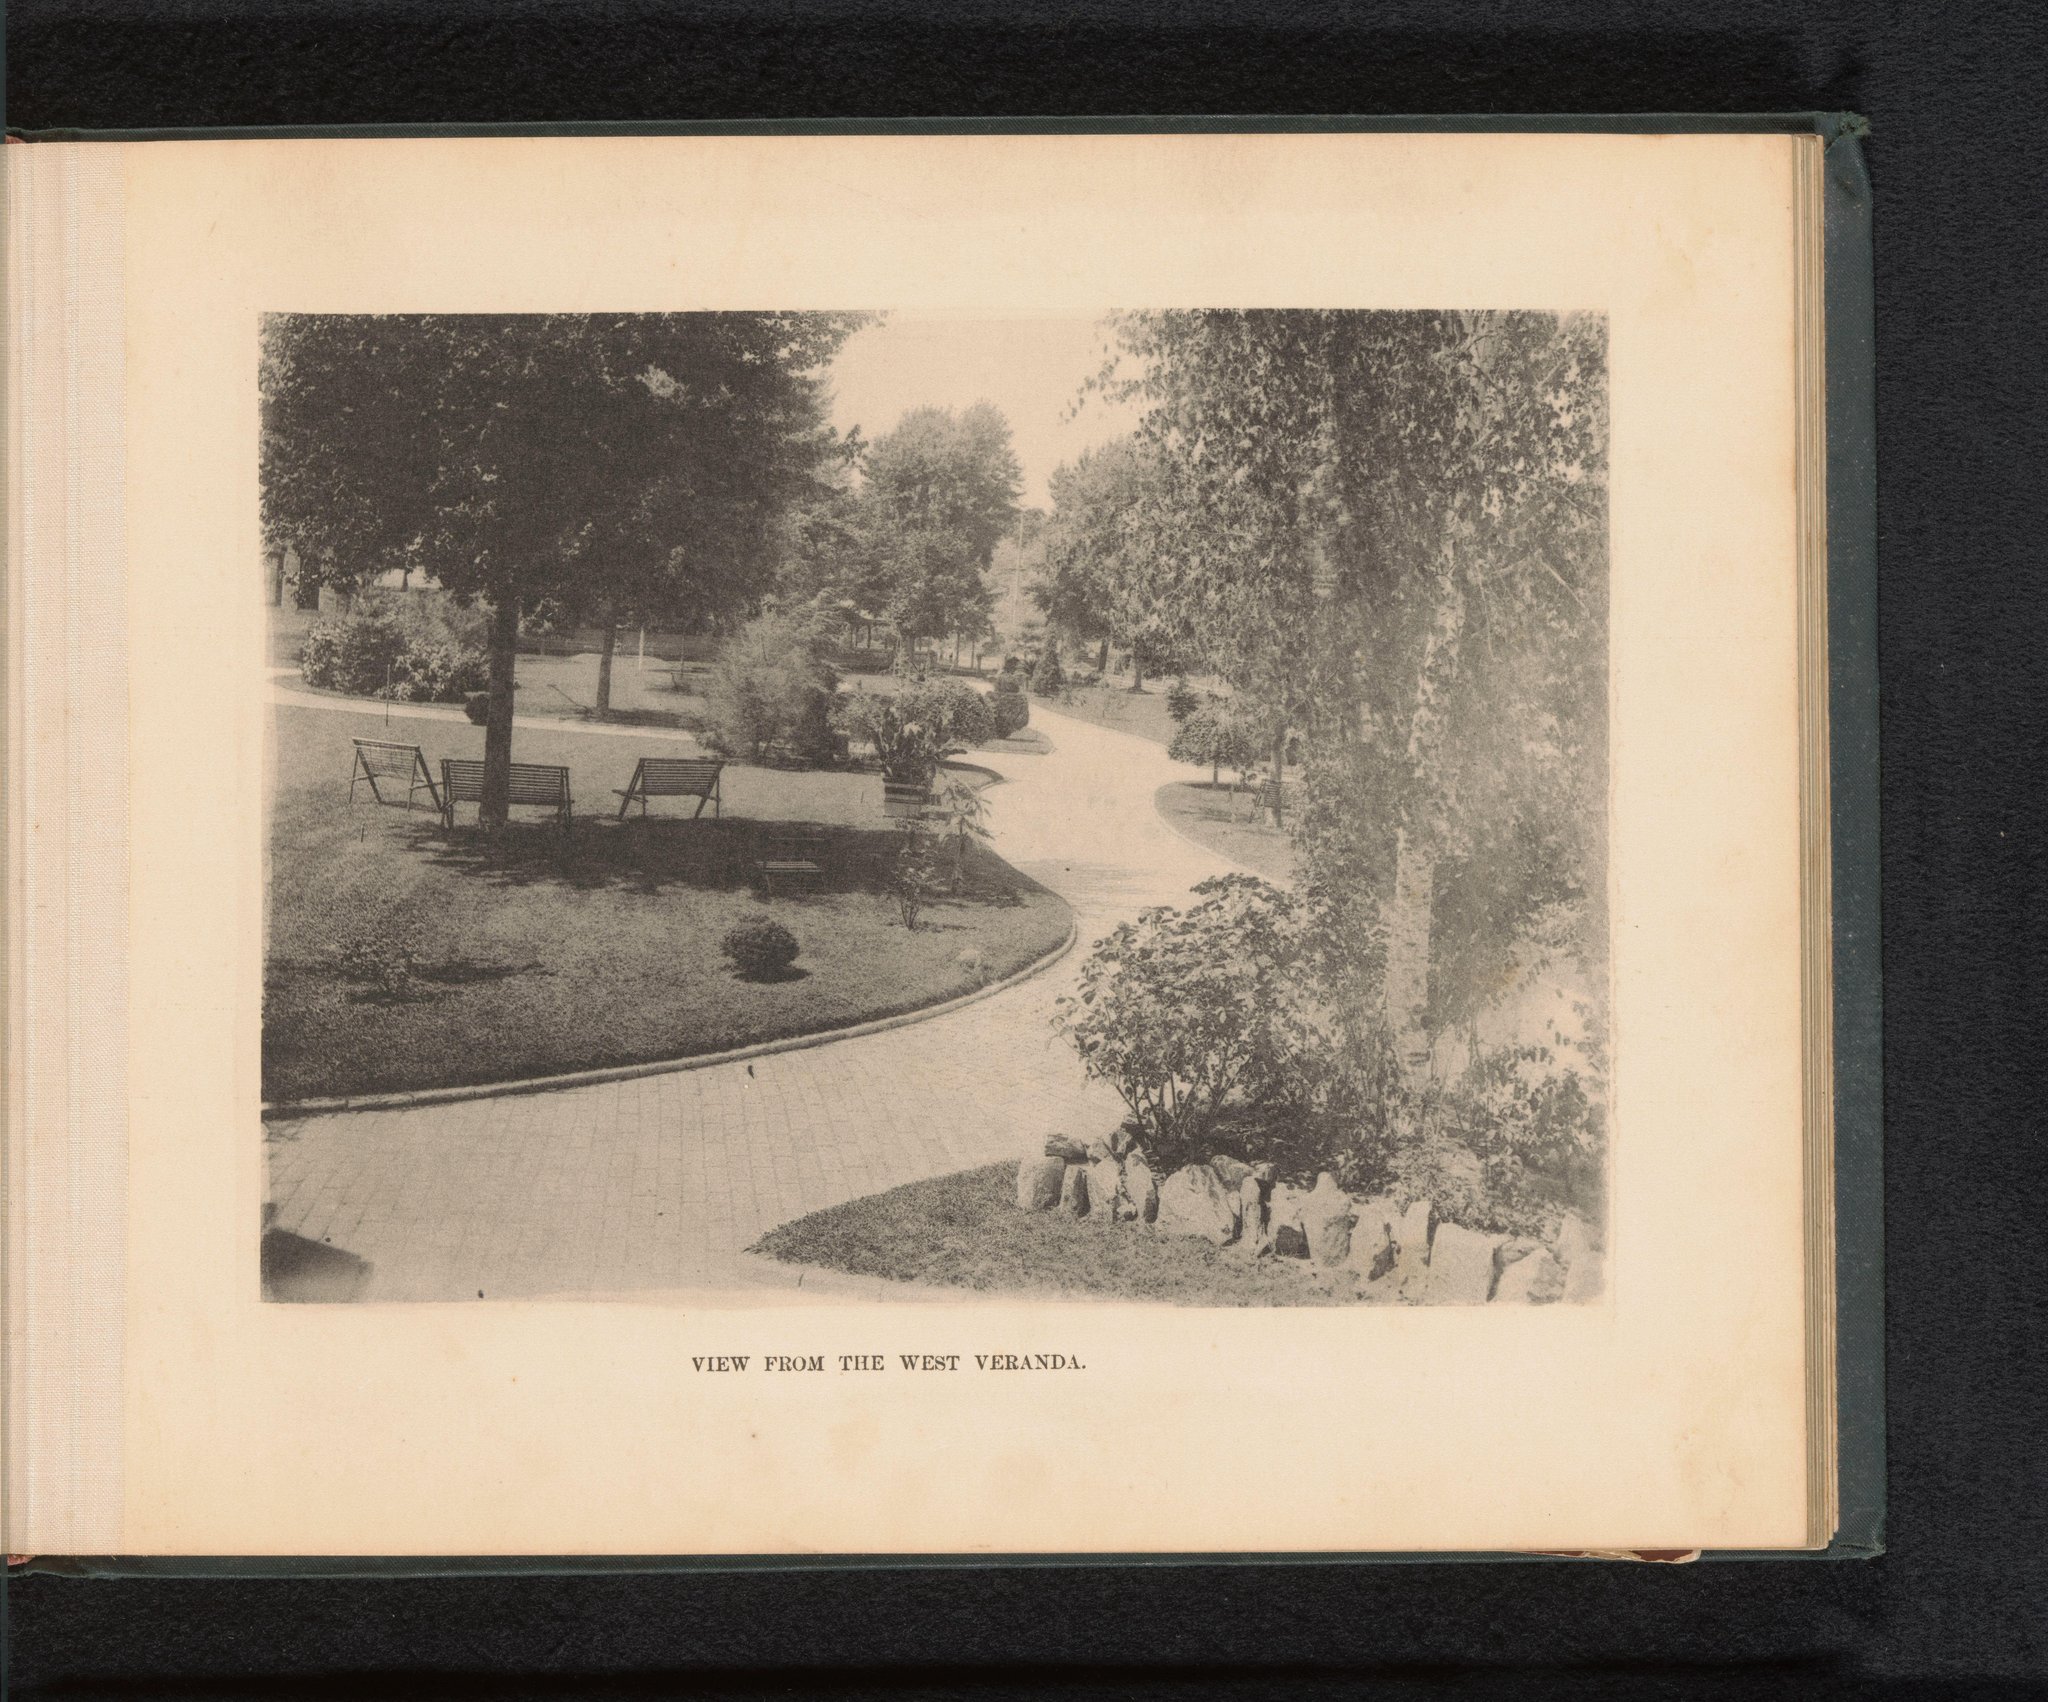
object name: page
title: Gezicht op de tuin op het landgoed van George Gill Green in Woodbury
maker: Anonymous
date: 1879-1889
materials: paper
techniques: photograph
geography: woodbury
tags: garden